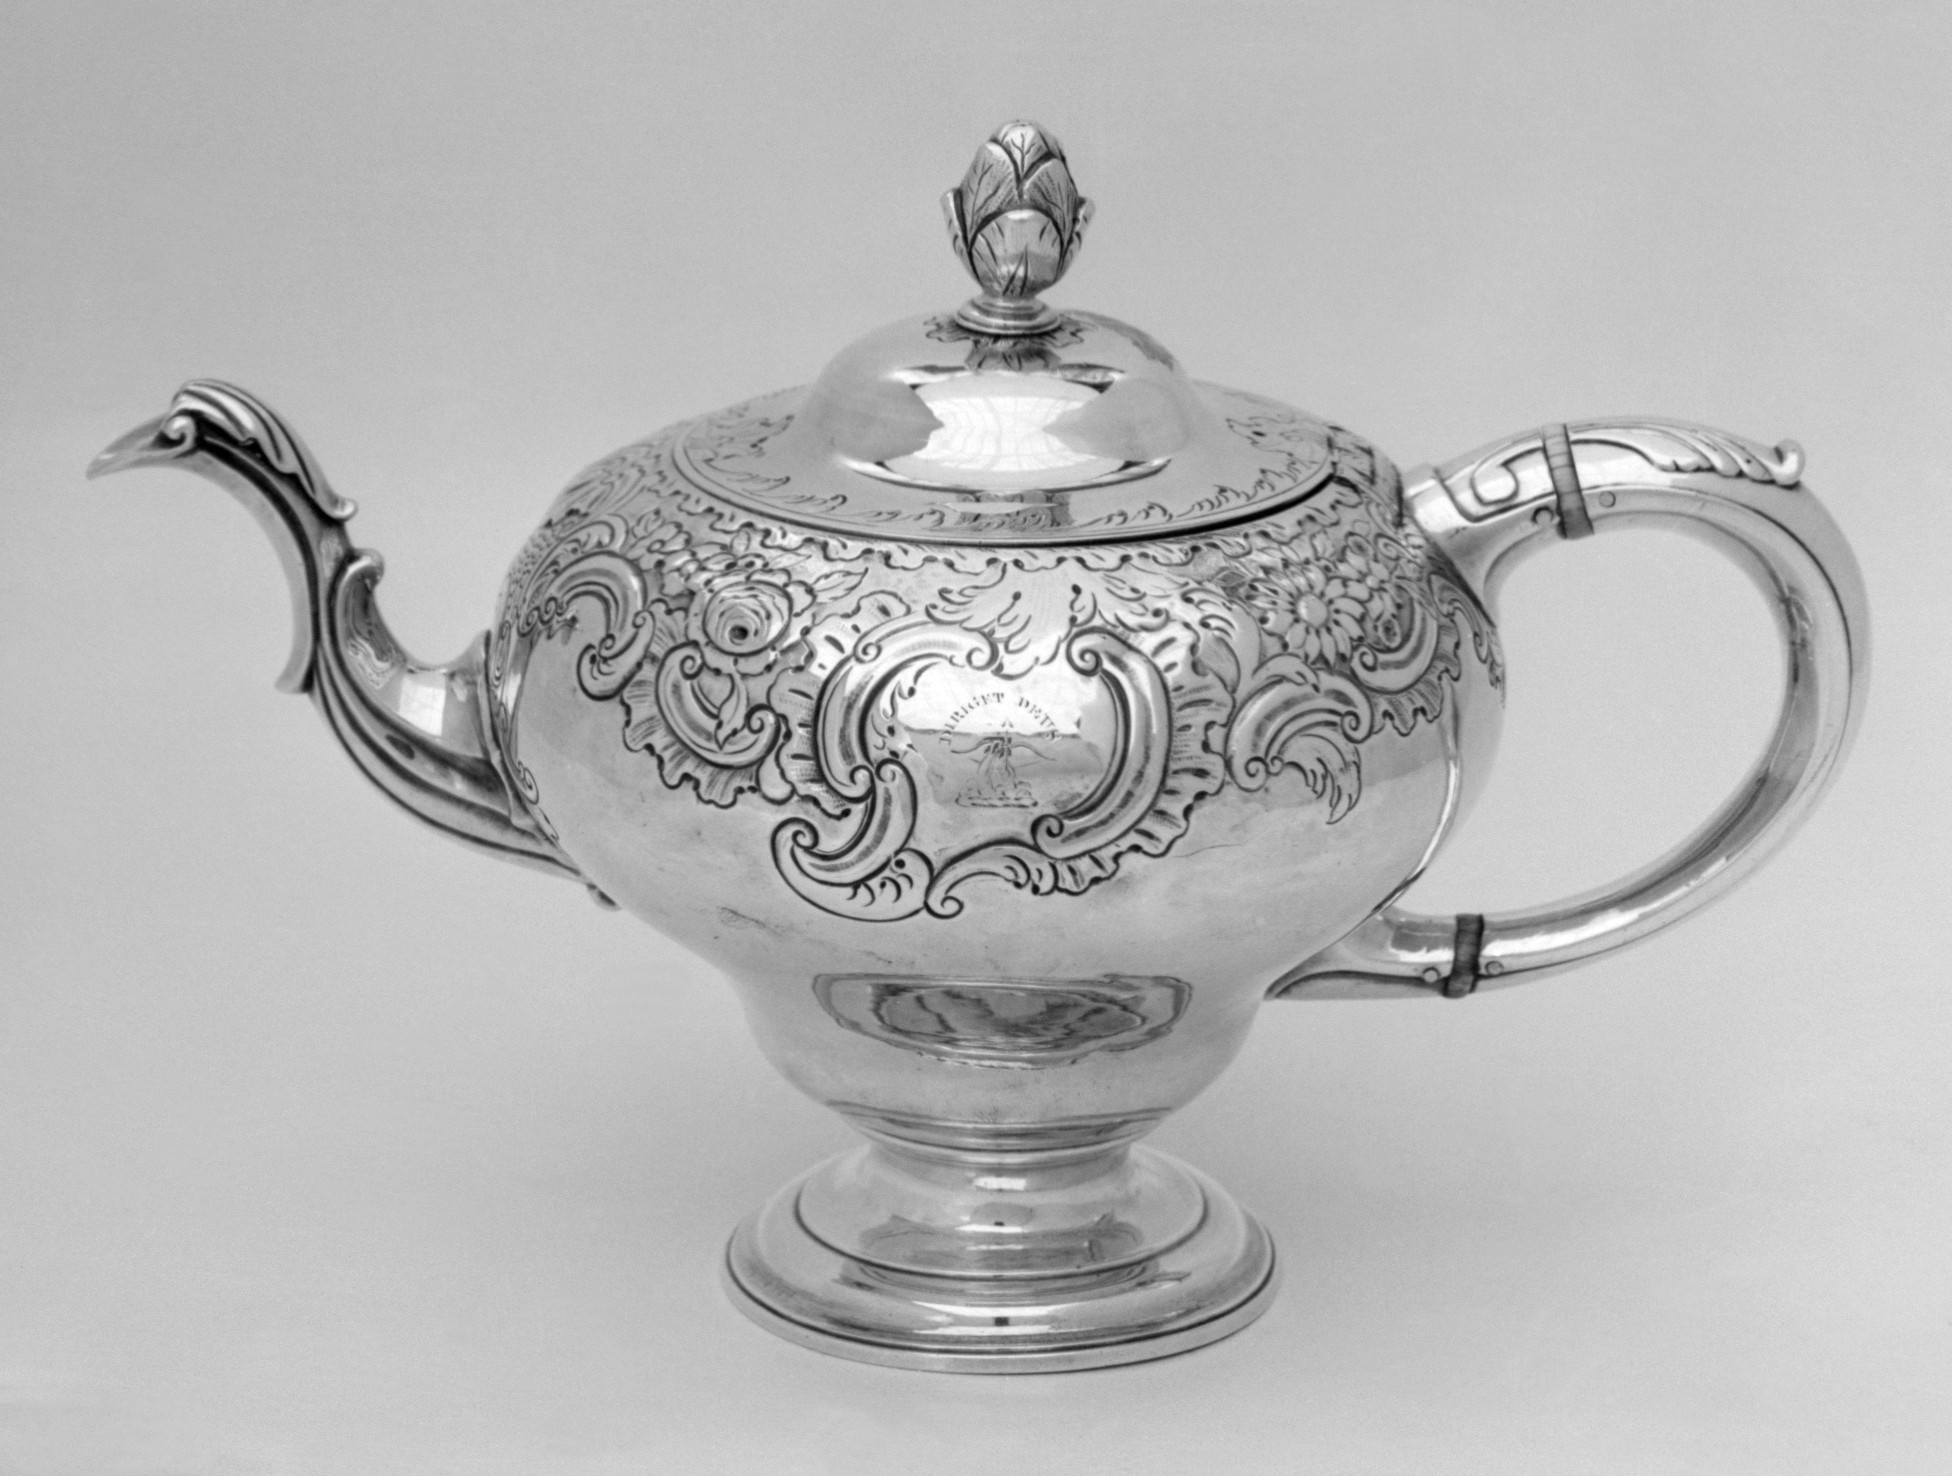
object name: teapot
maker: gillsland and ker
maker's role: maker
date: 1771-1772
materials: silver